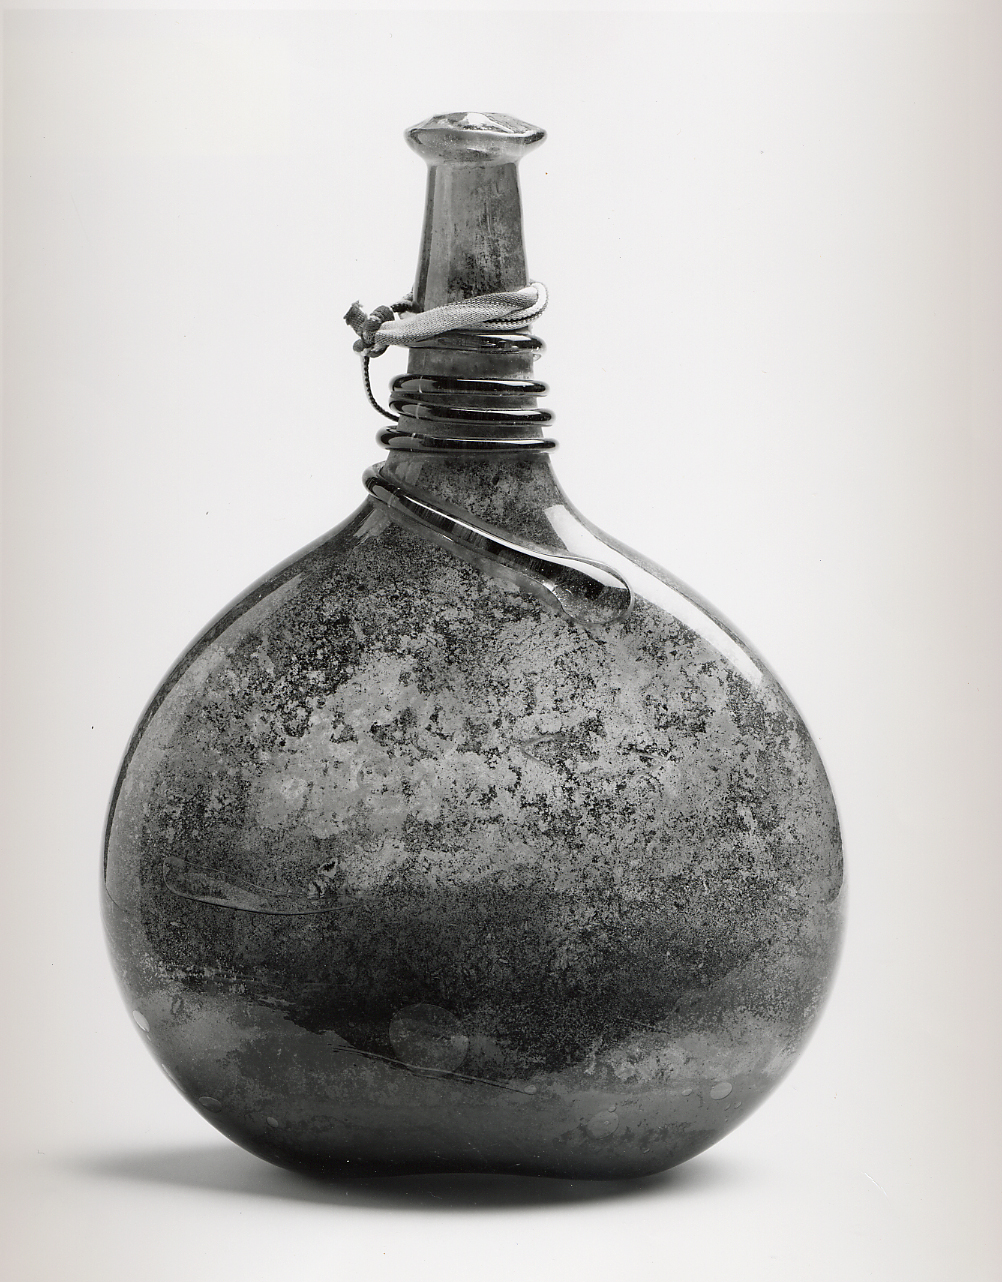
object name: bottle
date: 1701-1900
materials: glass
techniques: glassblowing, tooling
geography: iran